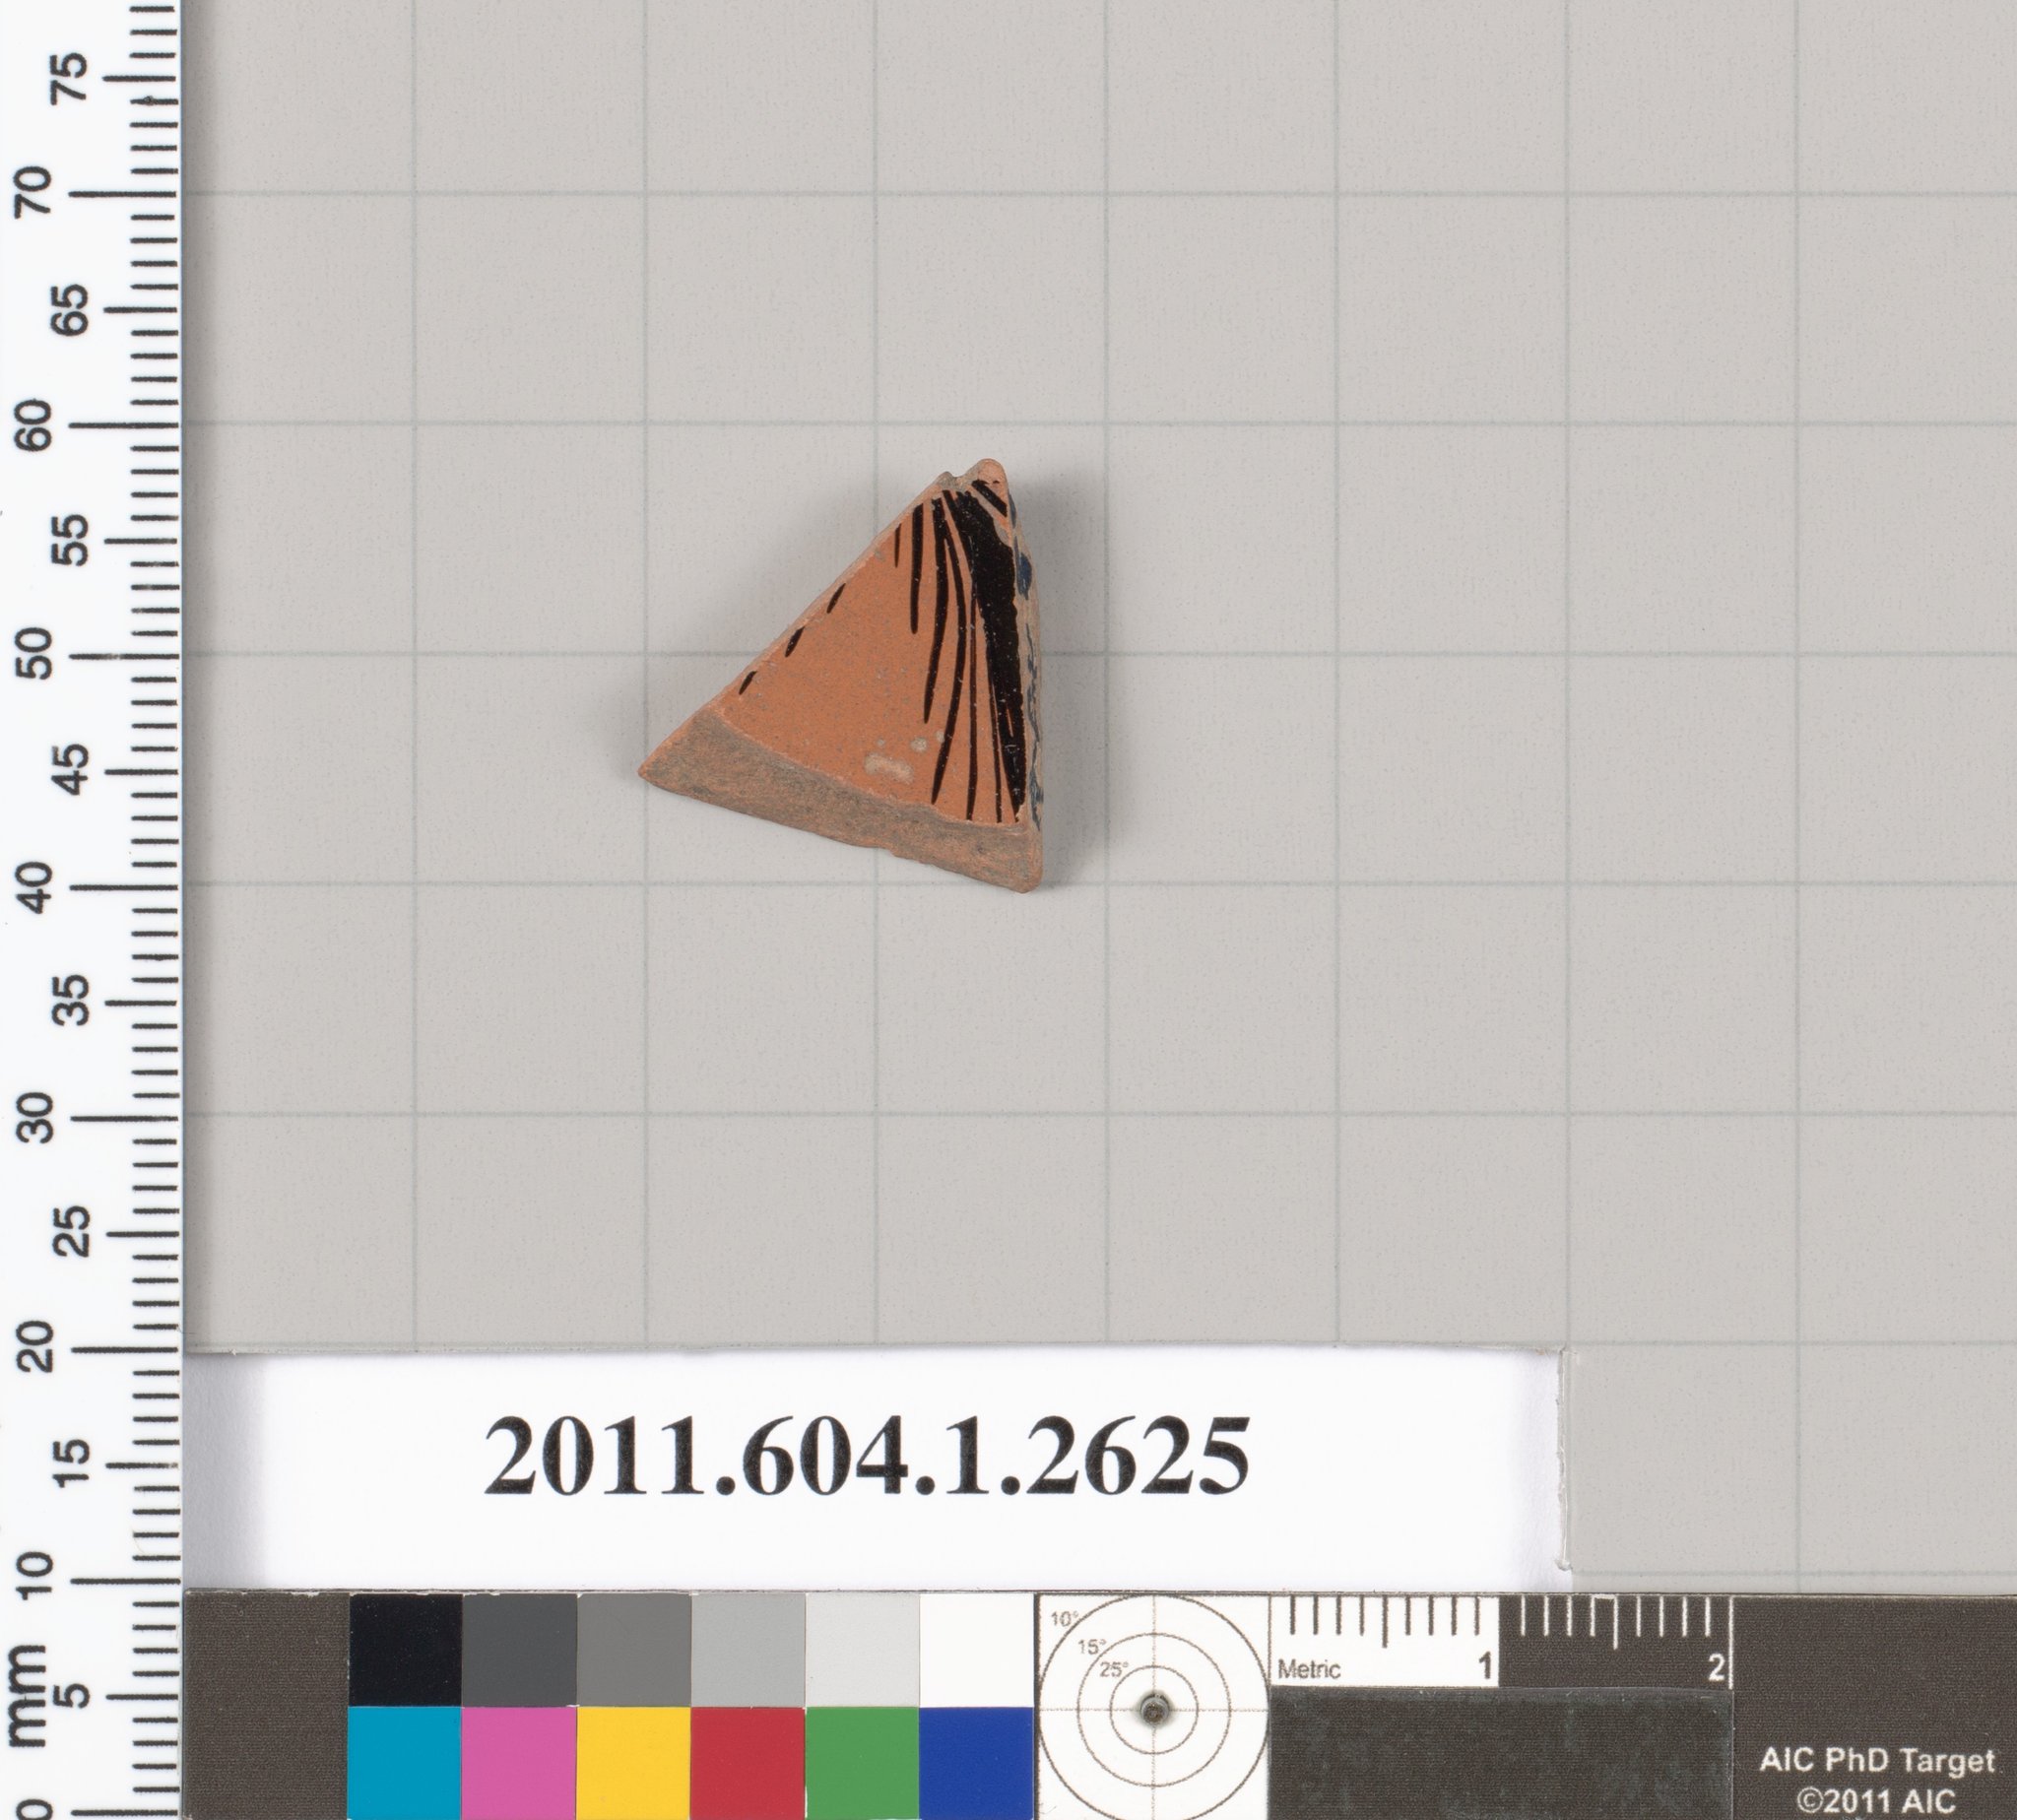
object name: kylix fragment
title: Terracotta fragment of a kylix (drinking cup)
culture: greek, attic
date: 490-480 BCE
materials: terracotta